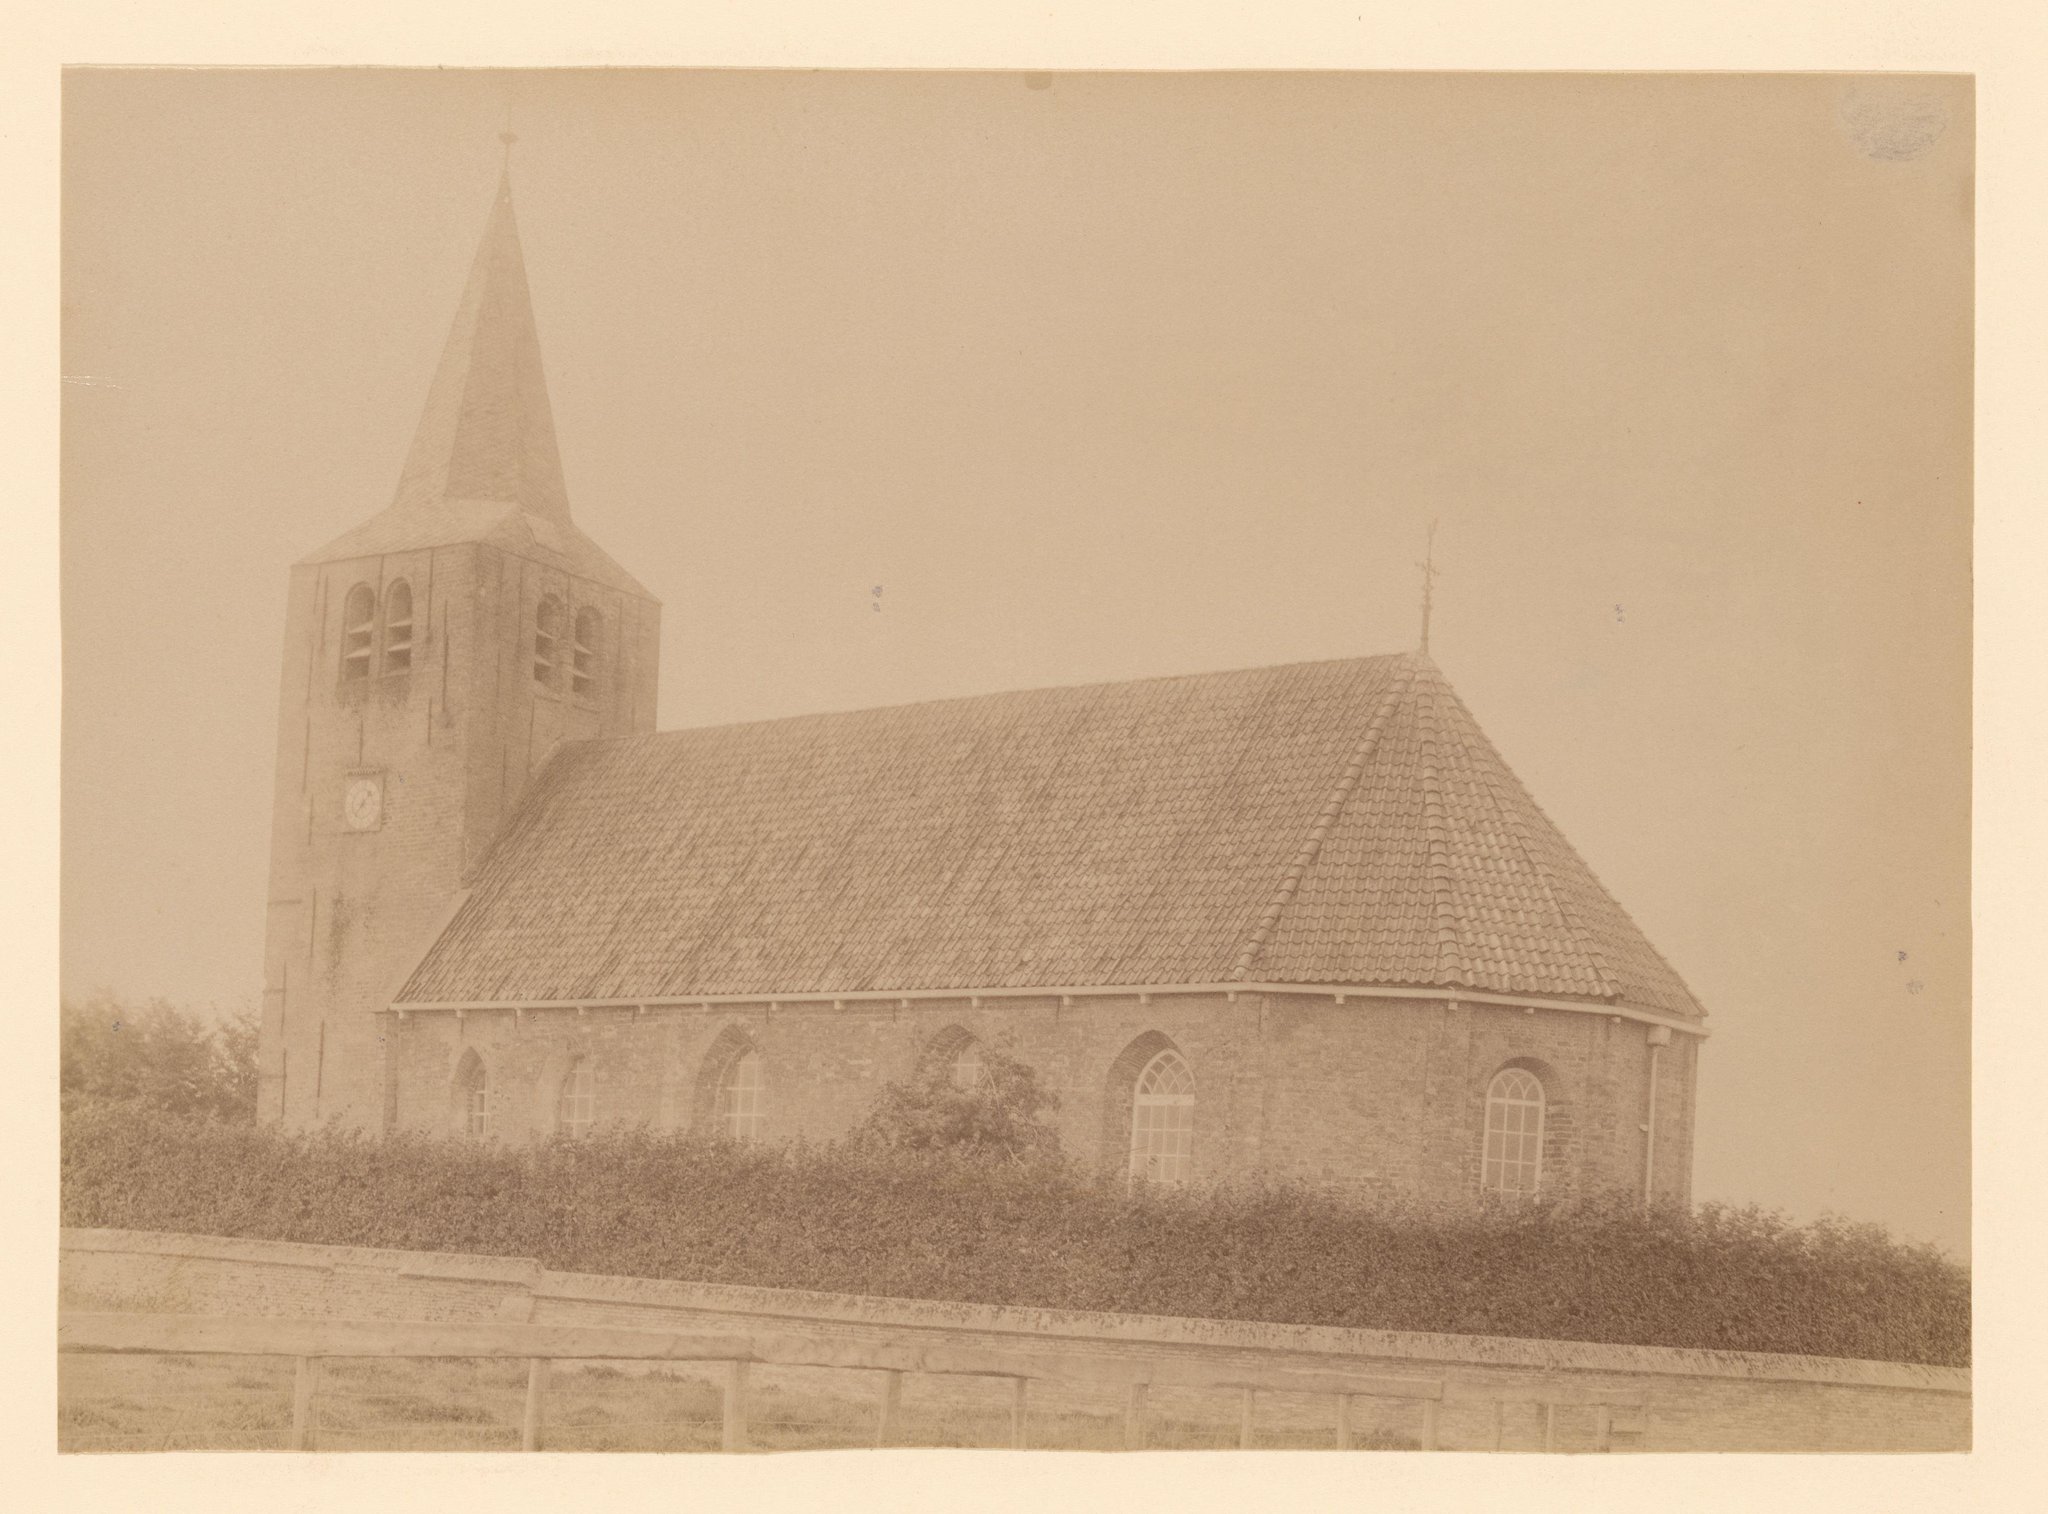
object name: photograph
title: Voormalige Hervormde Kerk te Oosterwierum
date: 1902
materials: cardboard, photographic support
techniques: albumen print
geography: oosterwierum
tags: church (exterior)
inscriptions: annotation: ‘Oosterwierum (Frieschland) / N.H. Kerk Aug 1902 / Baarderadeel’, annotation: ‘Oosterwierum/ Oosterwierum/ gem. Baarderadeel’